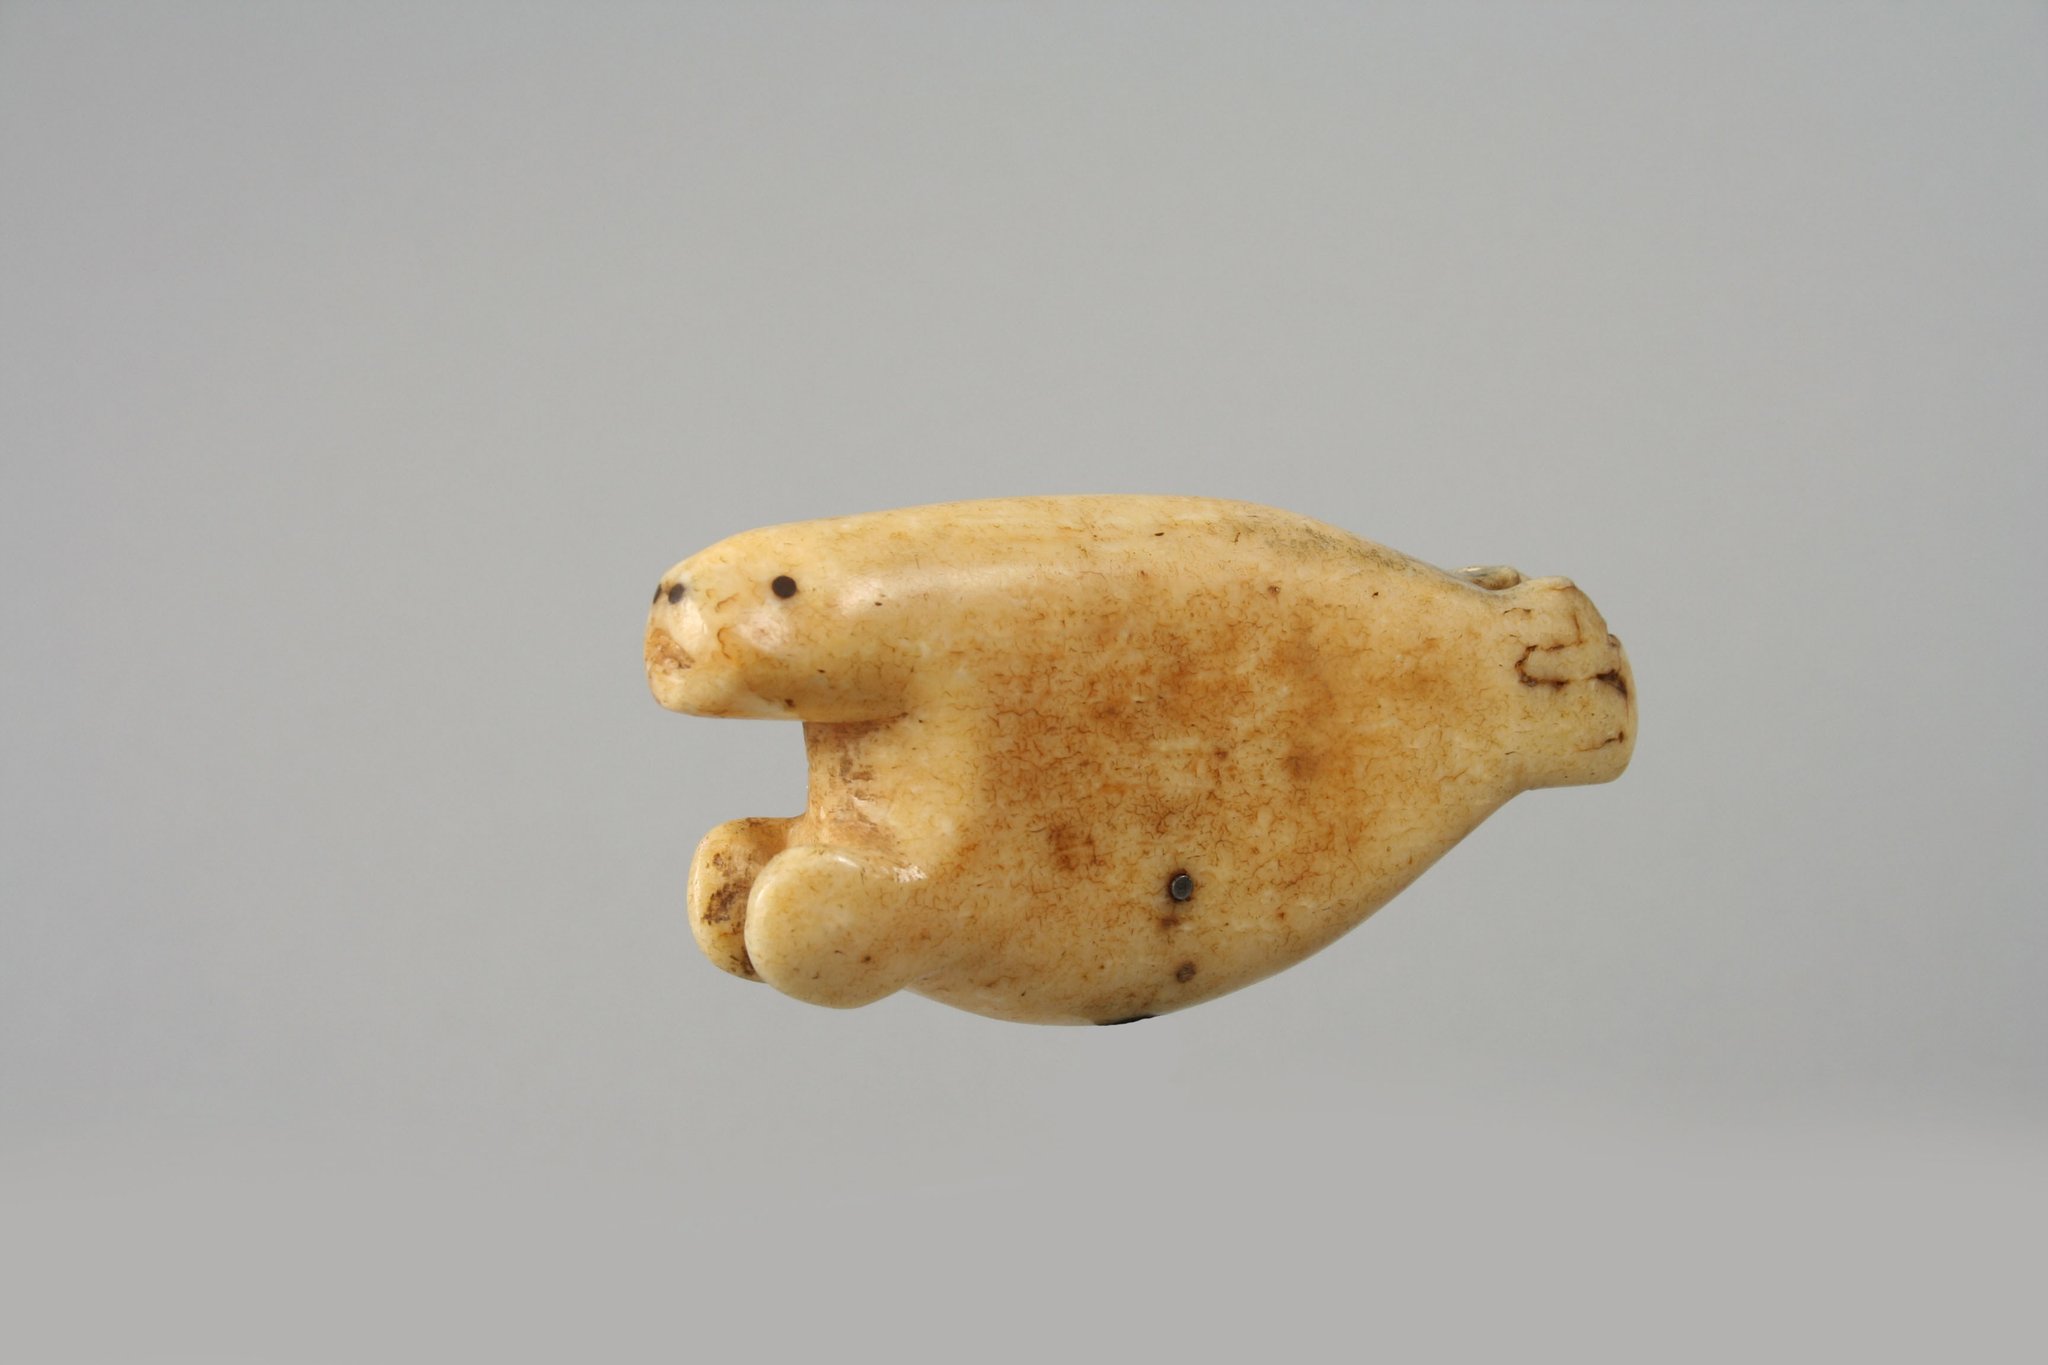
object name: figure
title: Walrus Ivory Seal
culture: inuit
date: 1701-1900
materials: ivory, steel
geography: canada